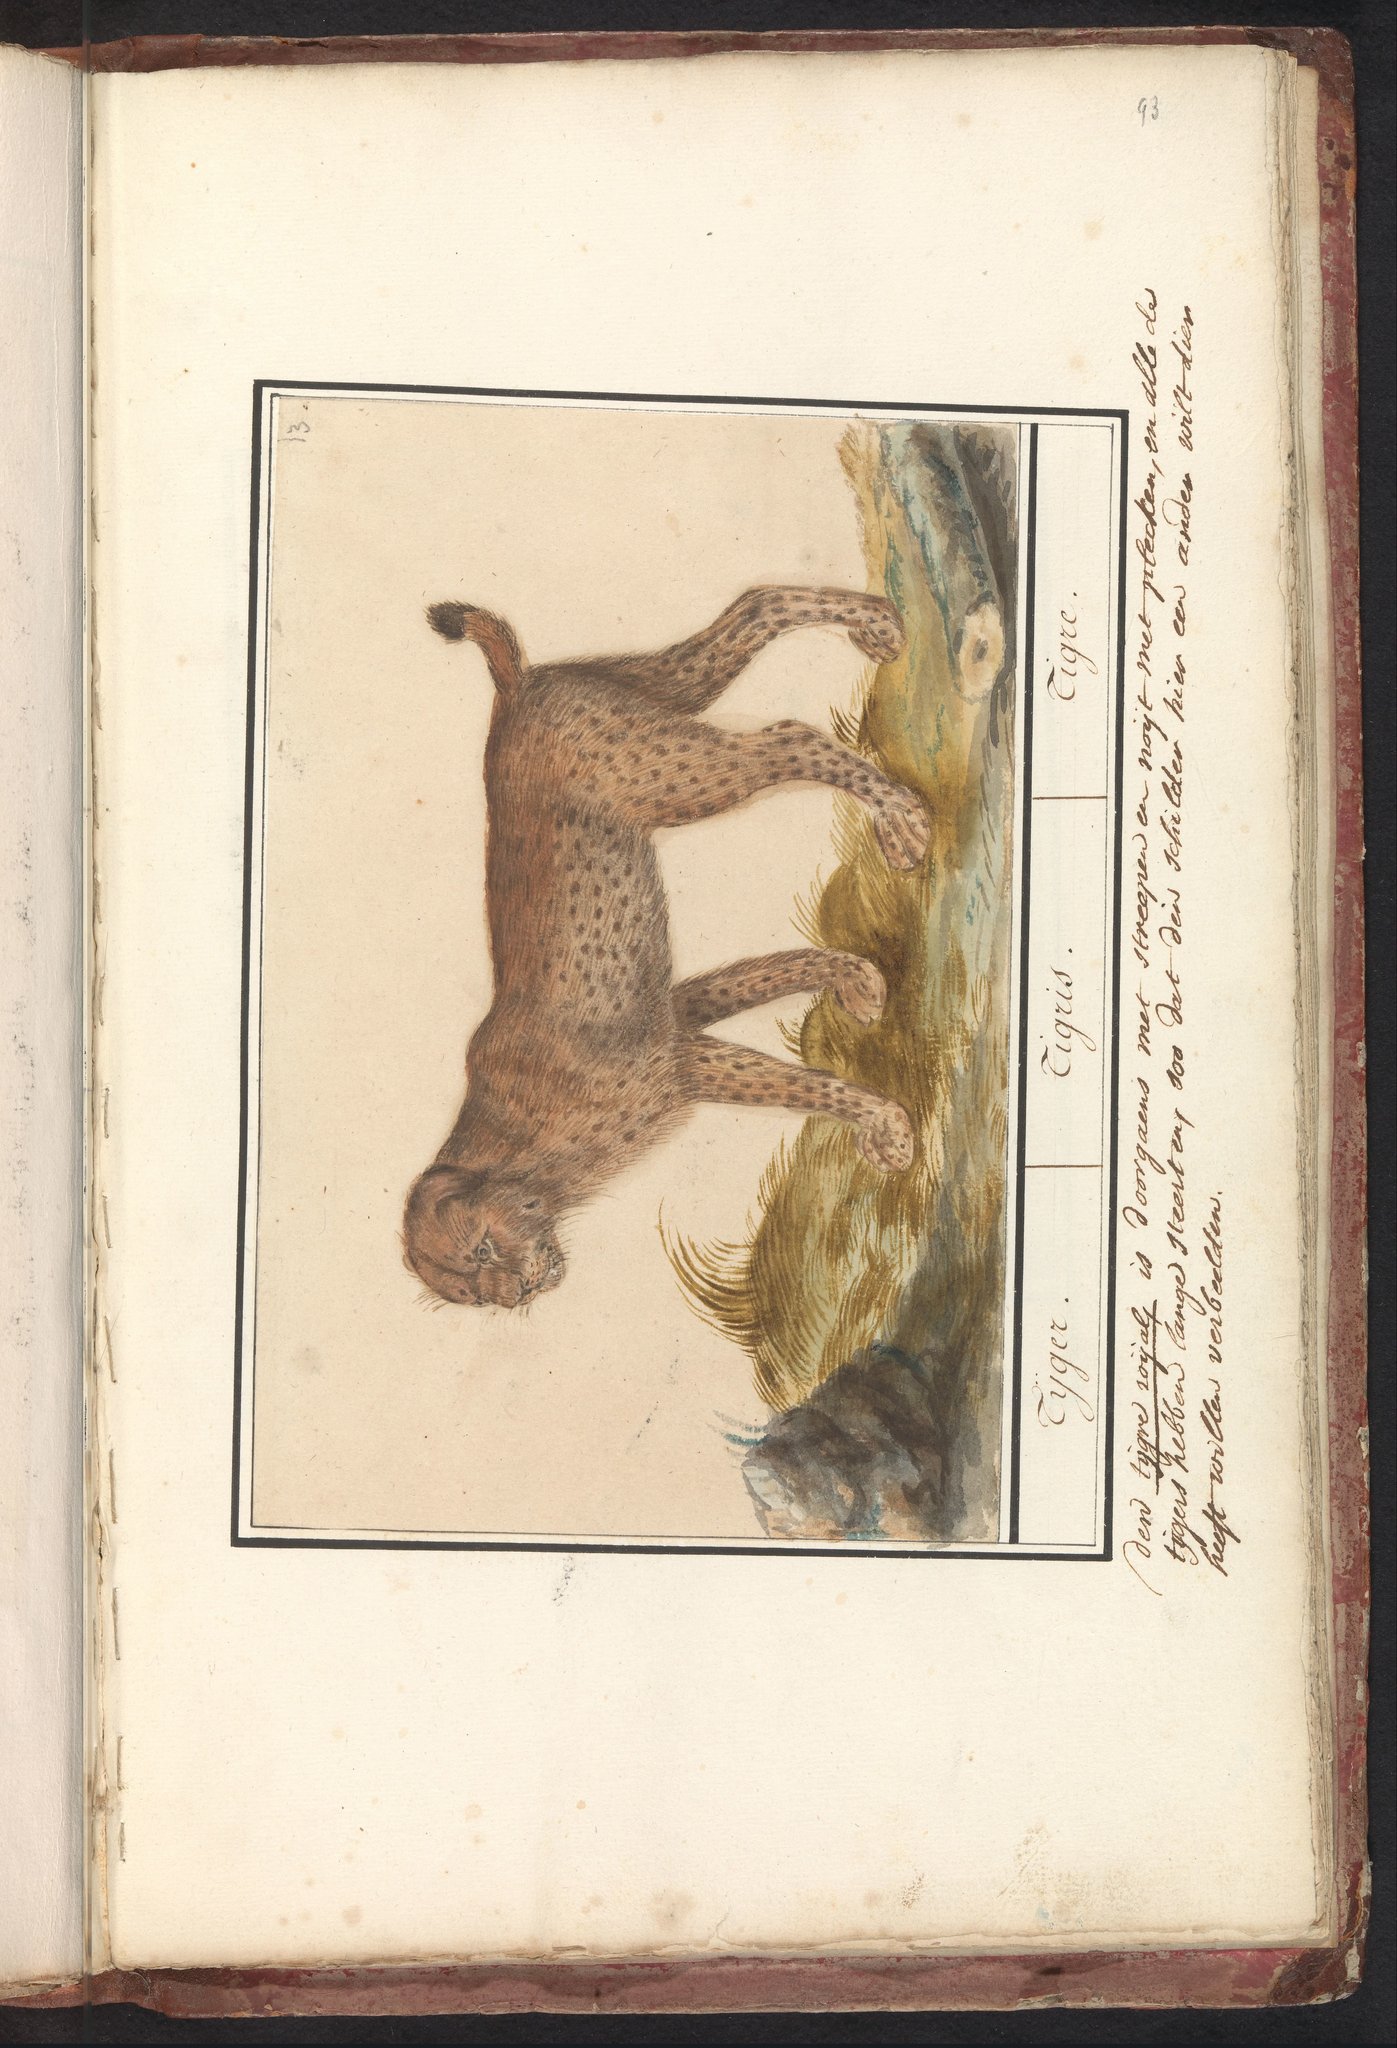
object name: drawing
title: Lynx (Lynx lynx)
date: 1596-1610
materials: paint, paper, watercolor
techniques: brush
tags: beasts of prey, predatory animals: lynx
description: In the early 19th century the mayor of Bruges, Van Huerne, had the Historia Naturalis re-bound. The drawings were pasted onto pages with framing lines containing the then-current Dutch, Latin, and French names of each creature – such as the tiger on this sheet. In the handwritten caption, however, it is rightly noted that a different animal is probably depicted here. After all, tigers have a long tail and stripes rather than dots.